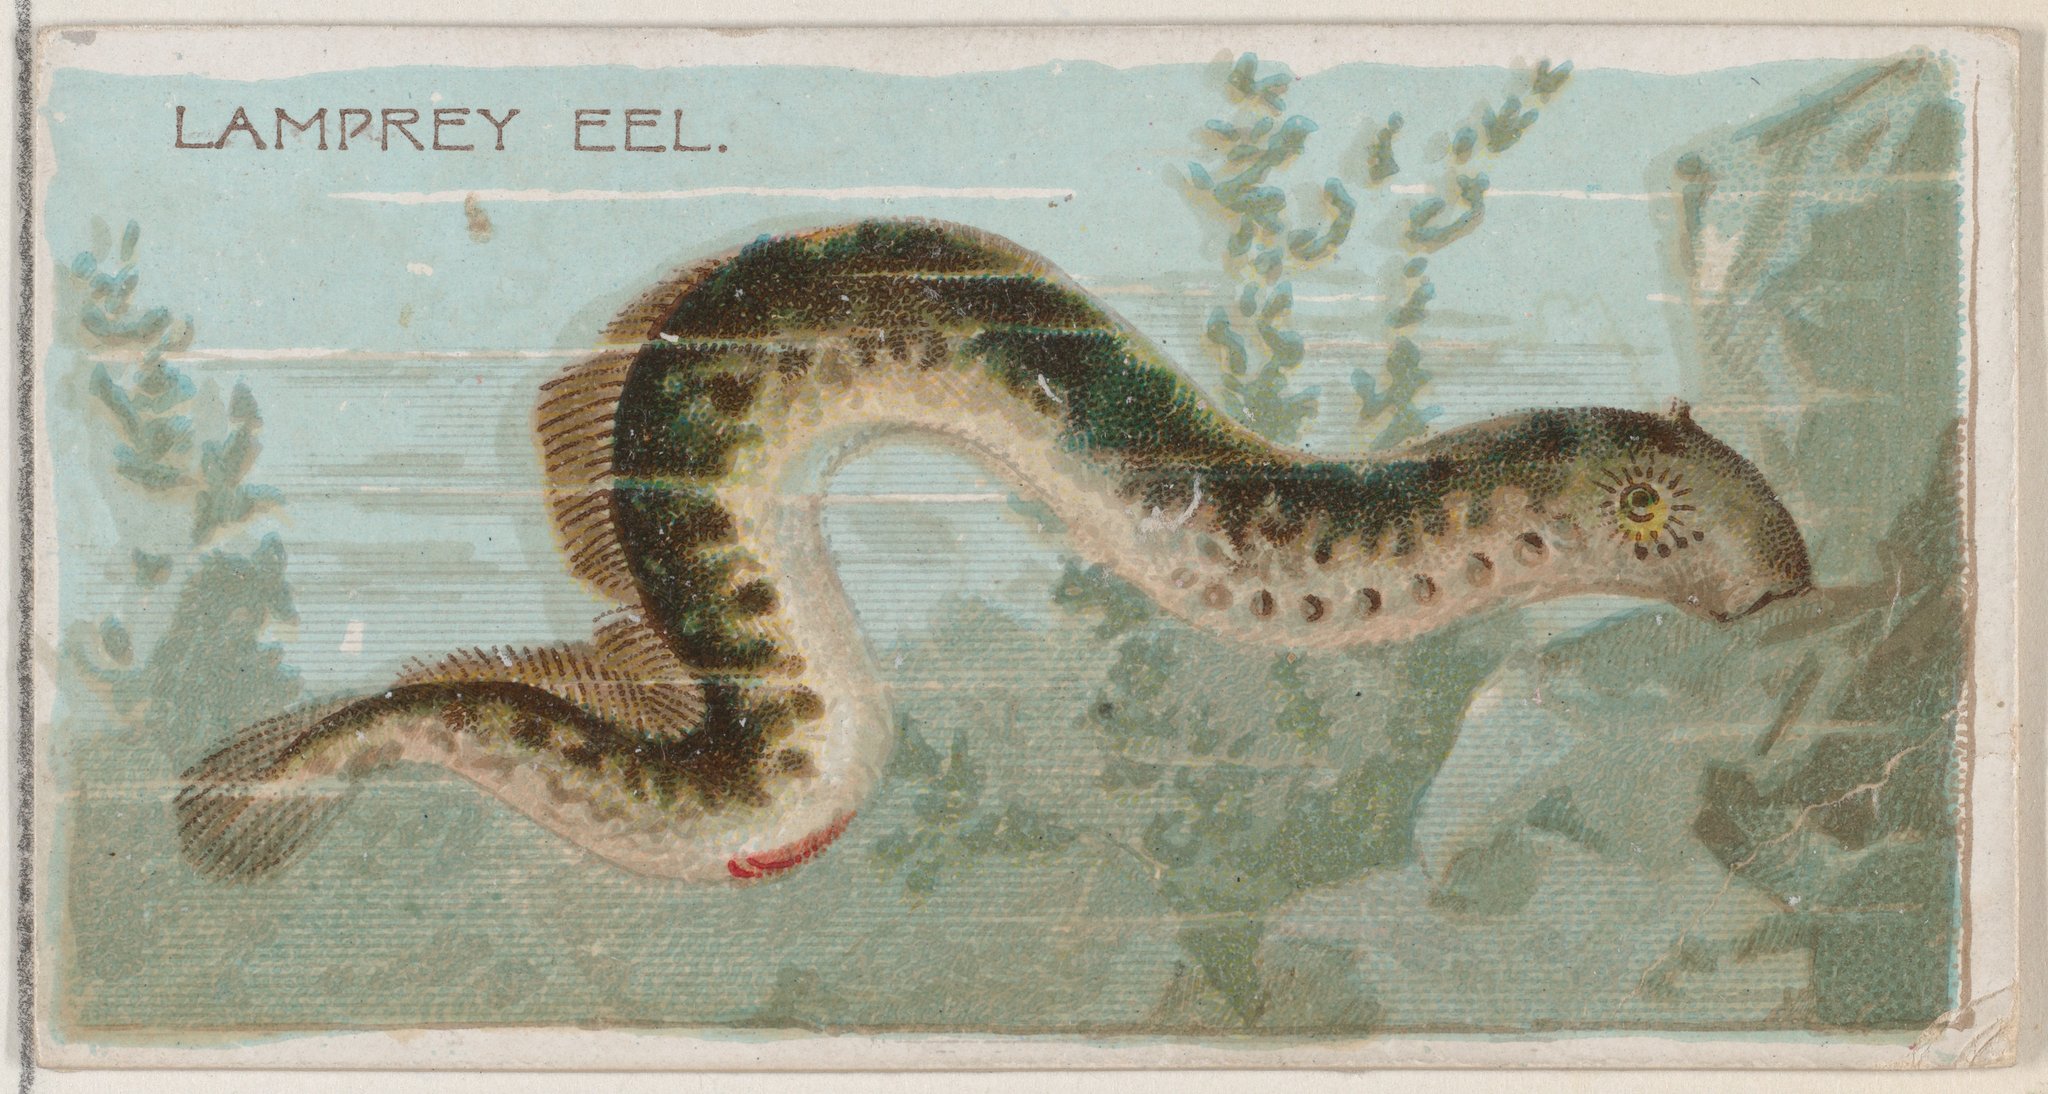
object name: print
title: Lamprey Eel, from the series Fishers and Fish (N74) for Duke brand cigarettes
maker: knapp & company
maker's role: lithographer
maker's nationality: american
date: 1888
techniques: color lithograph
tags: fish